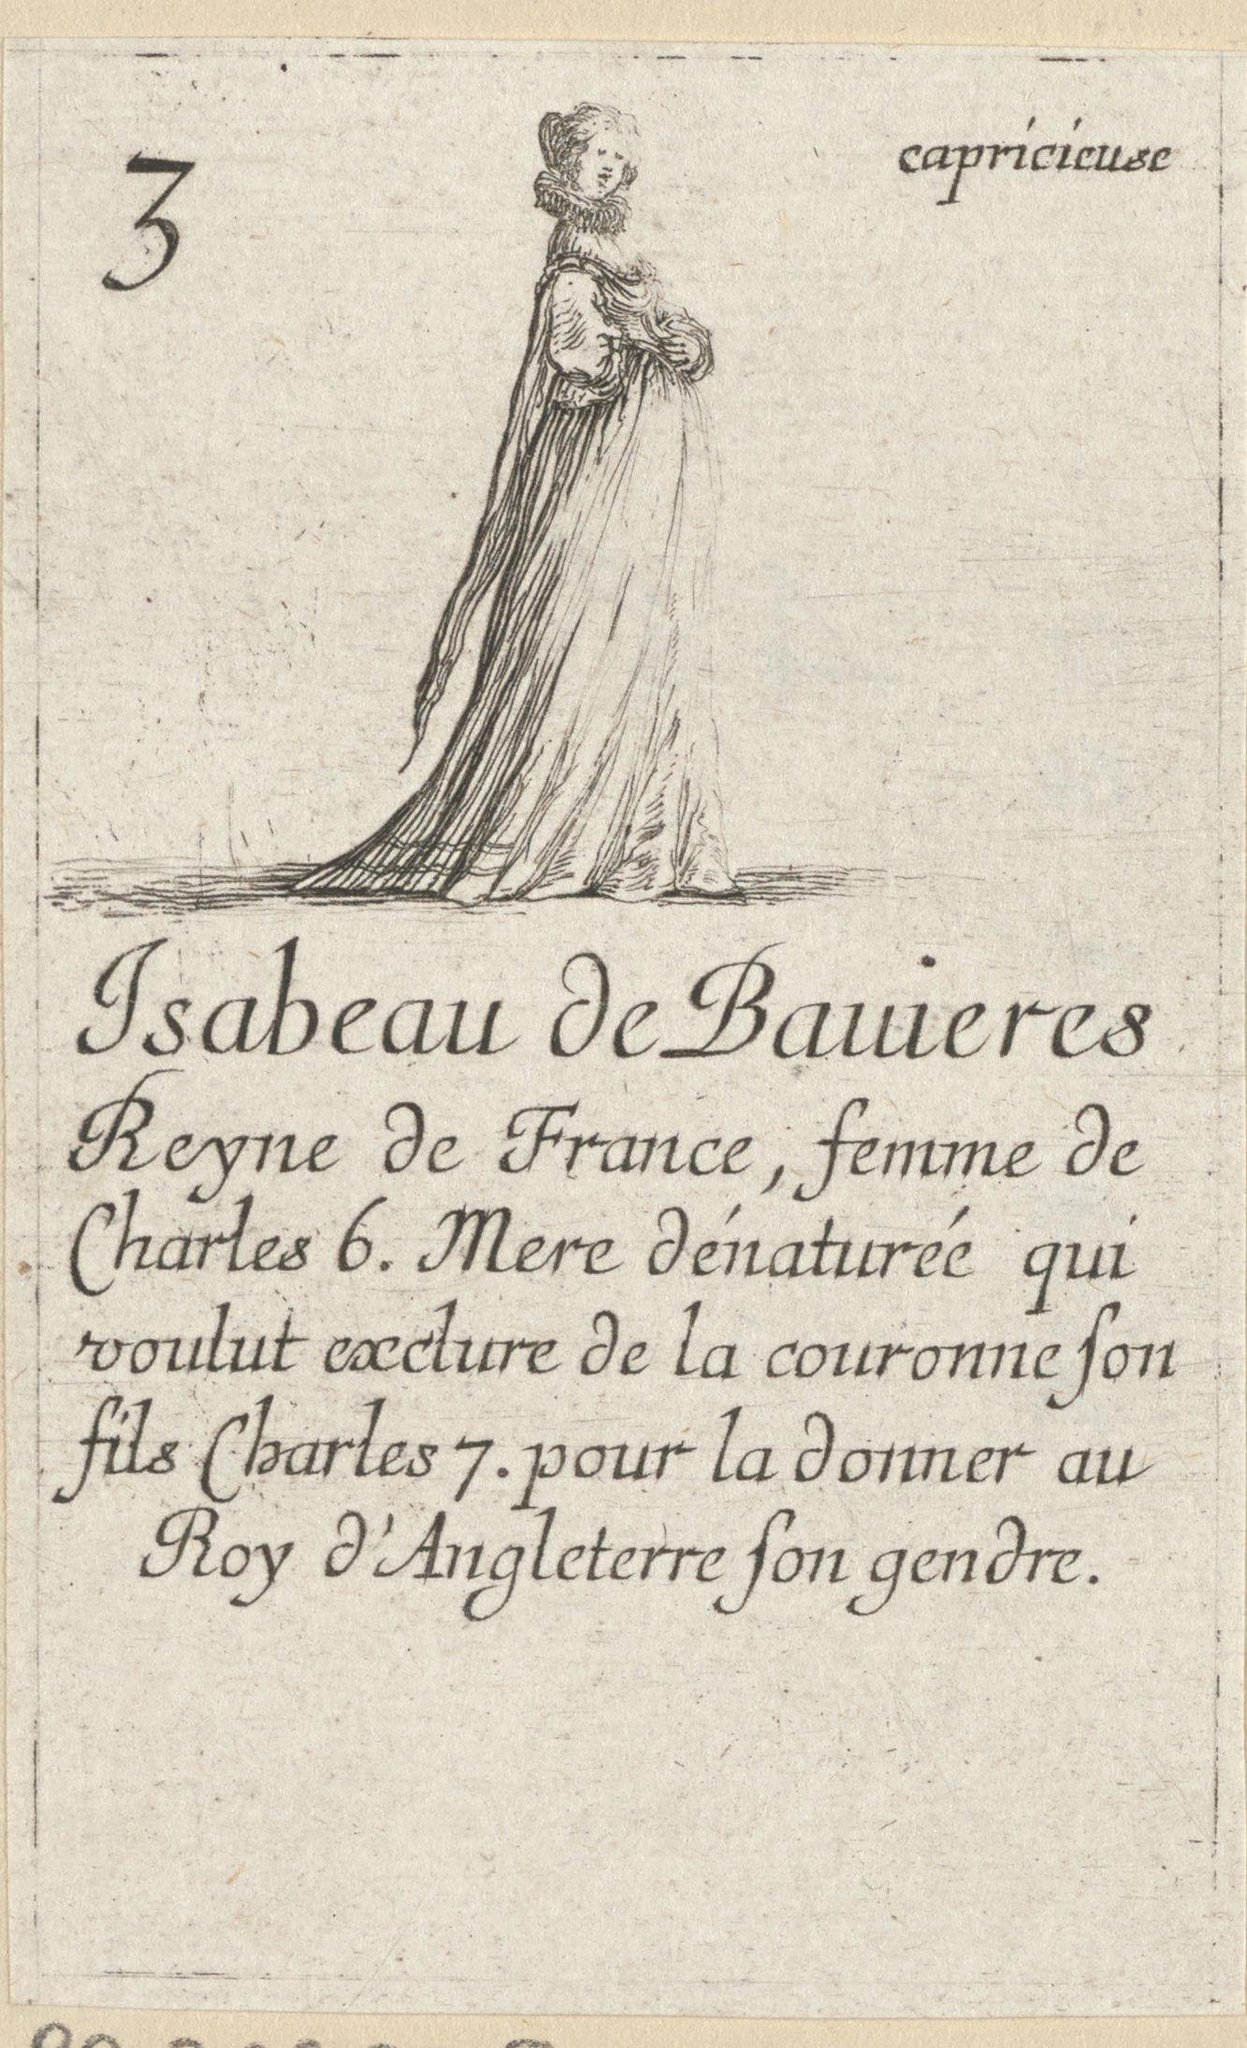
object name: print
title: Isabeau de Bauieres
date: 1620-1664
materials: paper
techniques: etching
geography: paris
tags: paris, ruler, sovereign - bb - female ruler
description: Deze prent maakt deel uit van een kaartspel met 52 kaarten met voorstellingen van beroemde koninginnen. De serie is uitgedacht door Jean Desmarests de Saint-Sorlin in opdracht van Kardinaal Mazarin. Het kaartspel werd gemaakt voor de jonge Lodewijk XIV, samen met het Jeu des Fables, Jeu de la Géographie en Jeu des Rois de France.